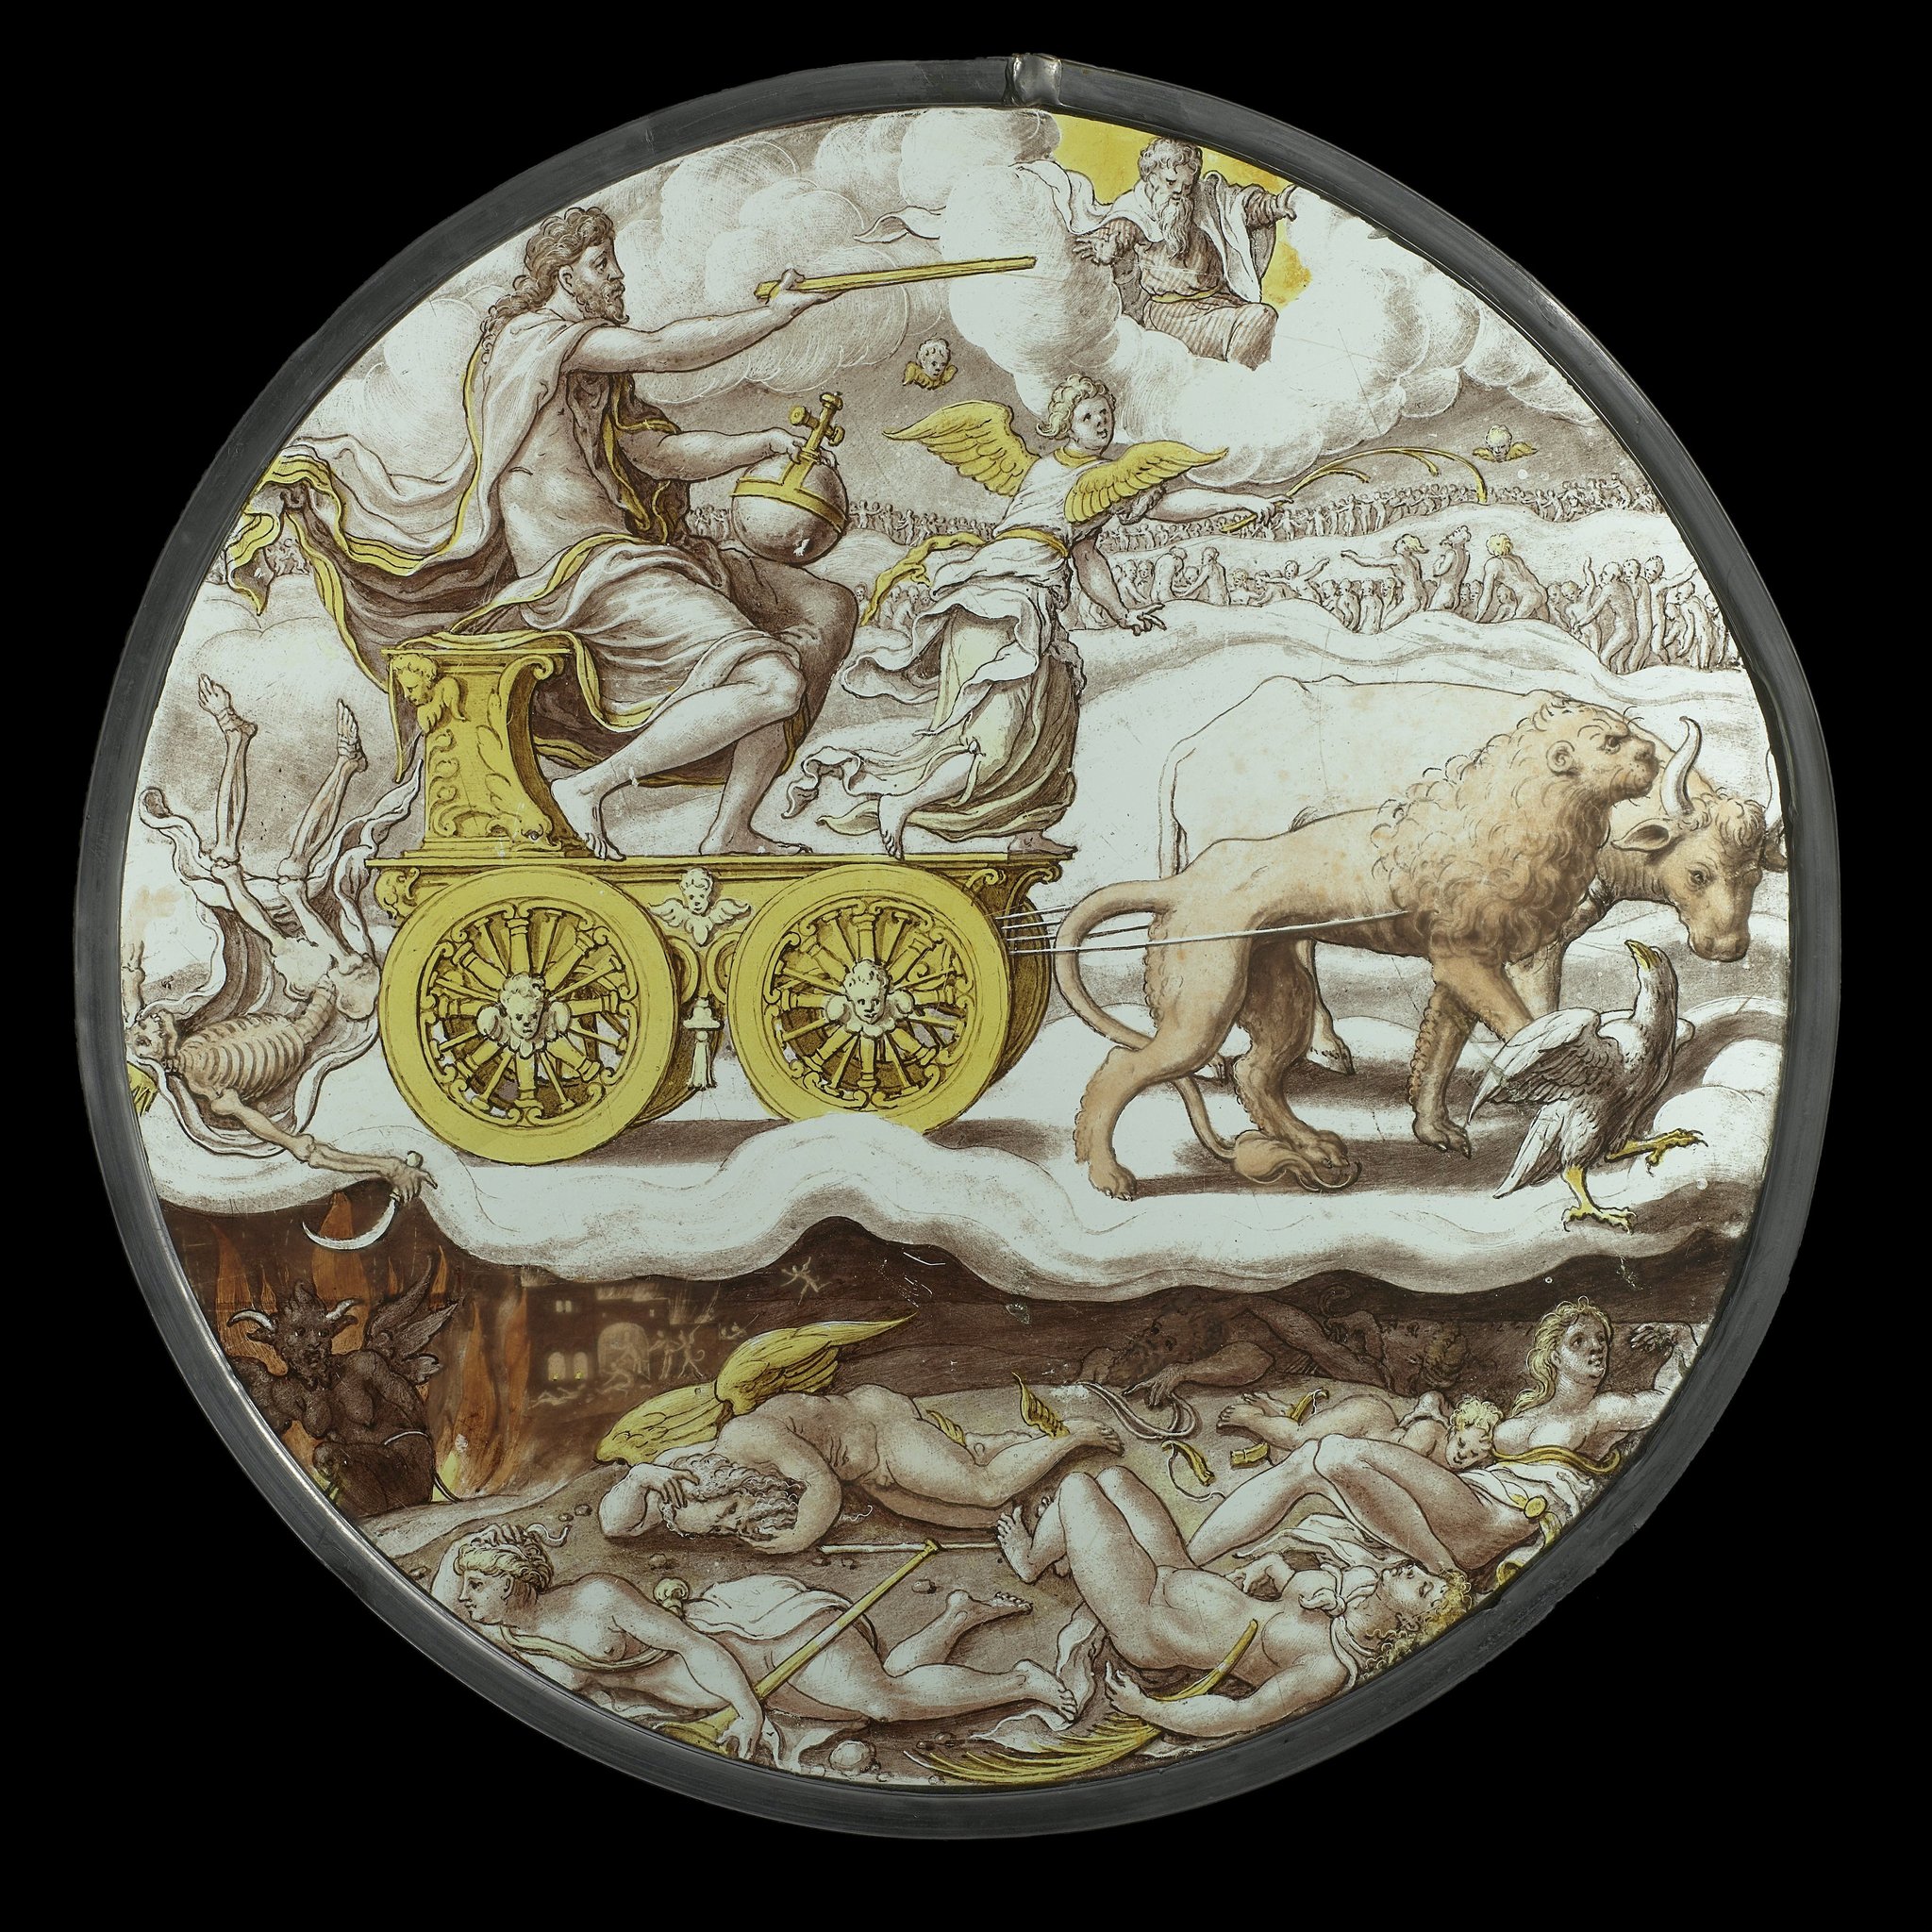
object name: light window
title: The Triumph of Eternity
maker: Anonymous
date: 1530-1540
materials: glass, lead, pigment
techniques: leading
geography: southern netherlands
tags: charity, 'caritas'; 'carità' (ripa) ~ one of the three theological virtues, 'castità ', 'pudicitia', 'vergogna honesta' (ripa), chariot, triumphal car, 'trionfo della divinità', 'triumphus aeternitatis'; 'carro della divinità', the four symbols of the evangelists, 'the apocalyptic beasts', triumphant christ, e.g. on triumphal chariot, fame; 'fama', 'fama buona', 'fama chiara' (ripa), father time, man with wings and scythe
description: Ronde gebrandschilderde ruit met voorstelling van de Triomf van de Eeuwigheid. De Eeuwigheid is voorgesteld door Christus, tronend op een klassieke zegekar, die wordt getrokken door een leeuw en een os, symbolen van de evangelisten Marcus en Lucas, en vergezeld van de engel van Mattheus en de adelaar van Johannes. Christus houdt een scepter in de ene en een in drie segmenten verdeelde aardbol in de andere hand. De zegekar rijdt op een grond van wolken. Onder de kar liggen verspreid over de grond personen die in andere scènes uit Petrarca's 'I Trionfi' triomfeerden, de Liefde, de Kuisheid, de Faam en de Tijd. Achter de kar tuimelt de Dood uit de wolken. Links onder zijn de hel en het vagevuur voorgesteld, waaruit een duiveltje oprijst. Boven de zegekar kijkt God uit de hemel toe, hoe de geredde zielen in een lange stoet door het paradijs trekken.